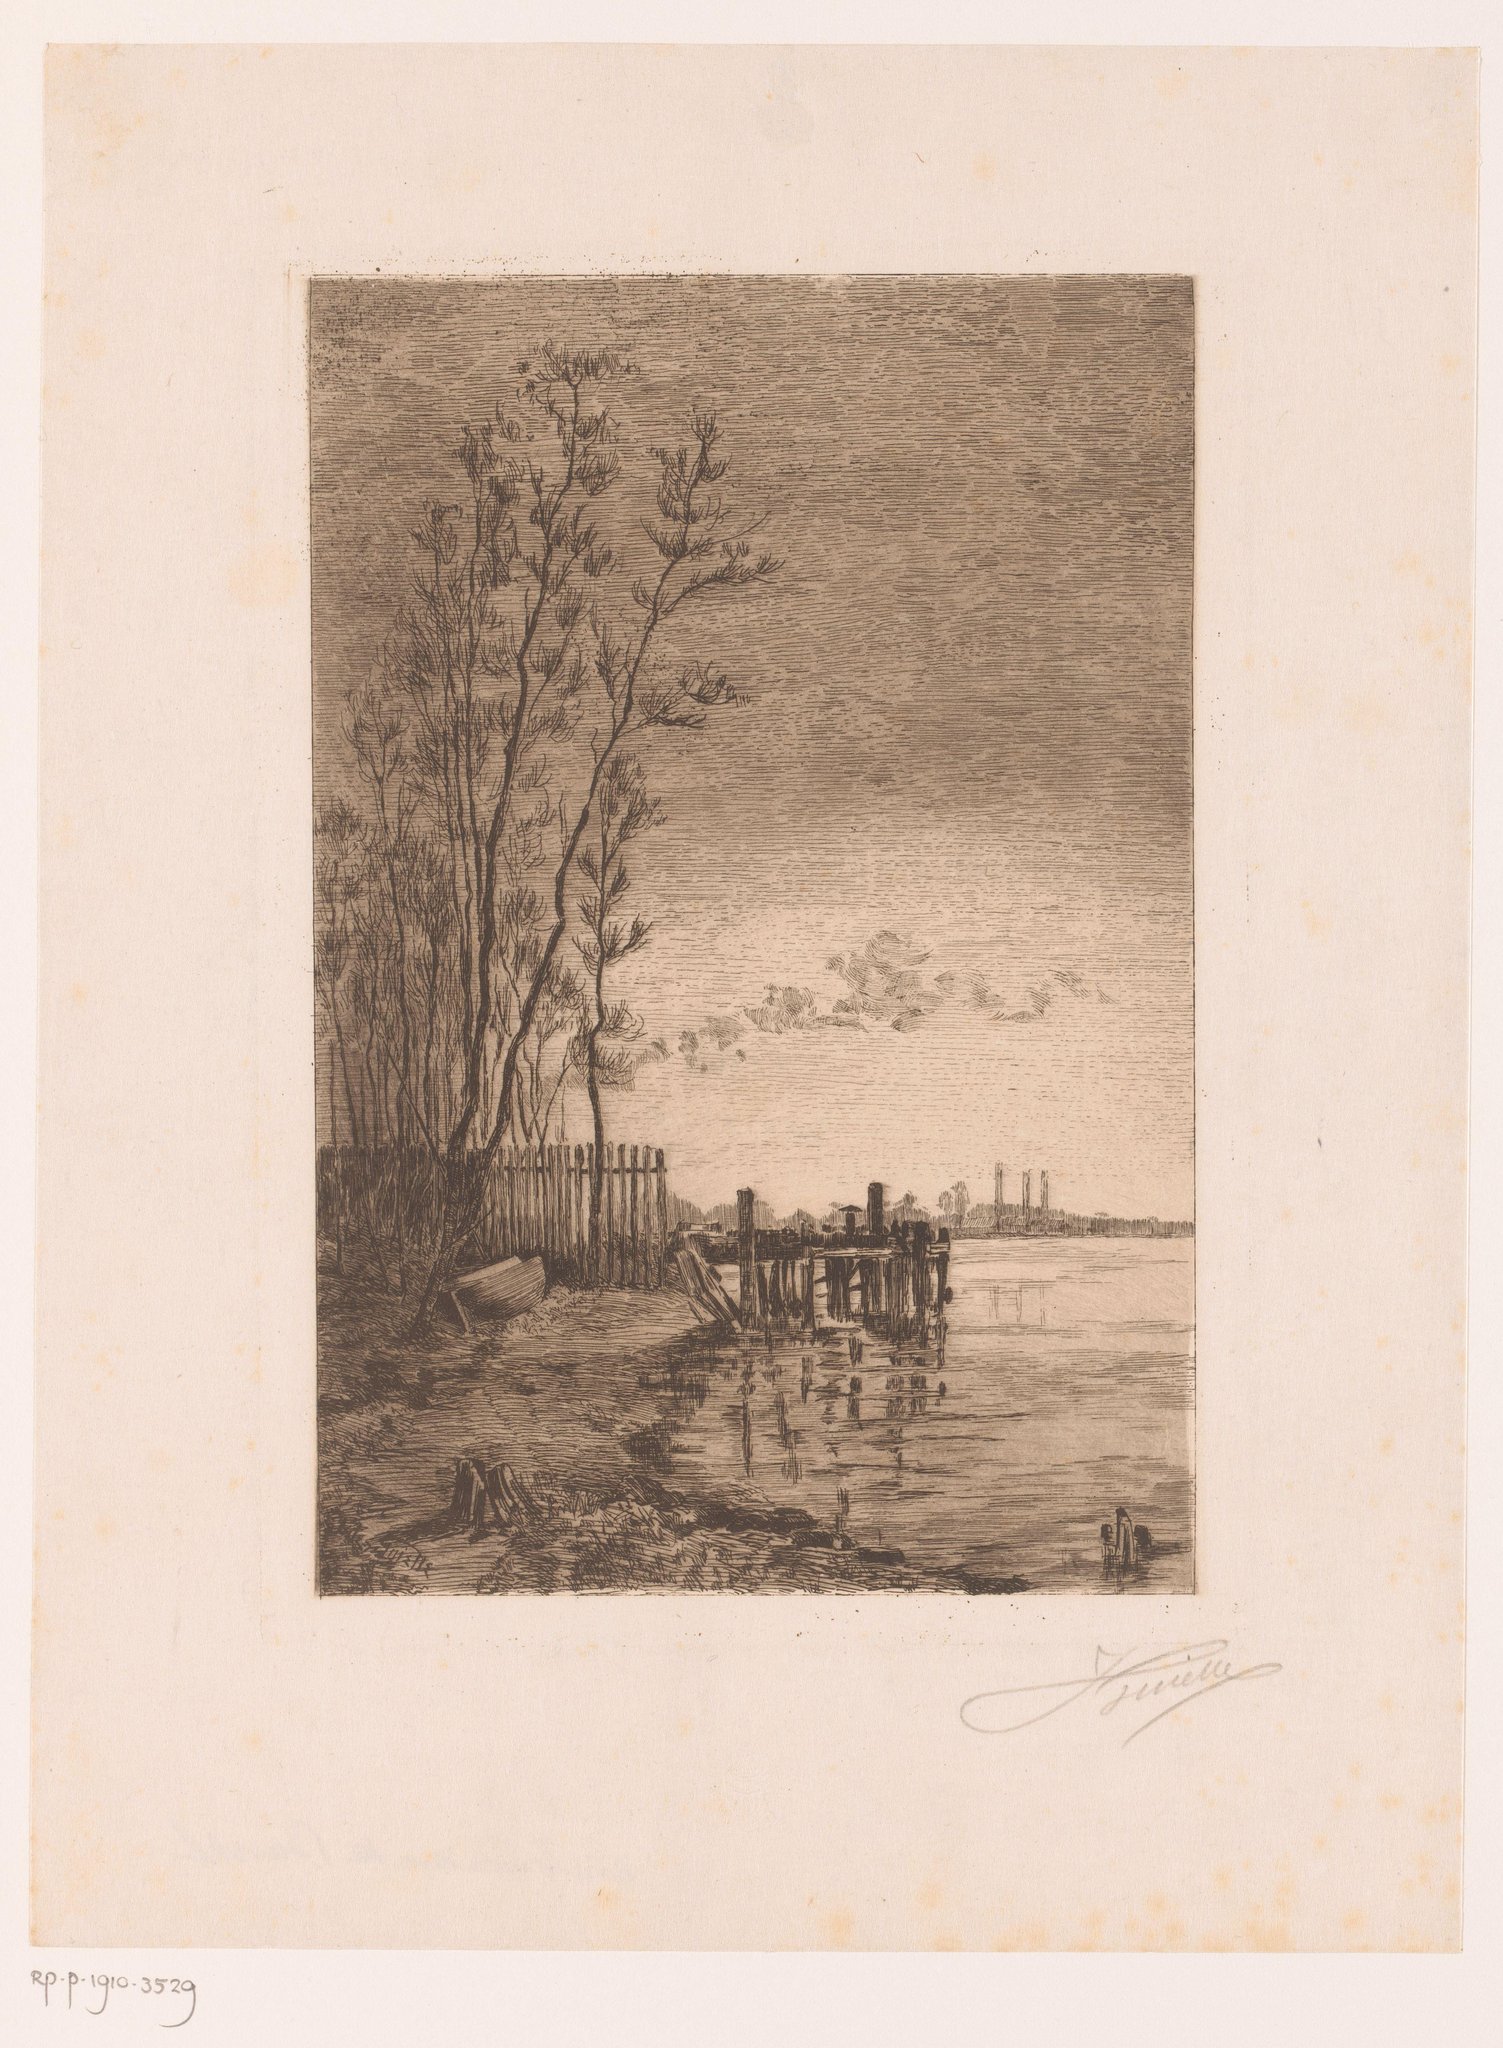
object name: print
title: Pier in een rivier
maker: jules guiette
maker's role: print maker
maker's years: 1852-1901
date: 1862-1901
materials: paper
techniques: etching, intaglio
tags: pier, quay, wharf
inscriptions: collector's mark: Lugt 2228, workshop stamp: ‘Antwerpsche Etsers 1880’, annotation: ‘embarcadere de Burcht (?)’